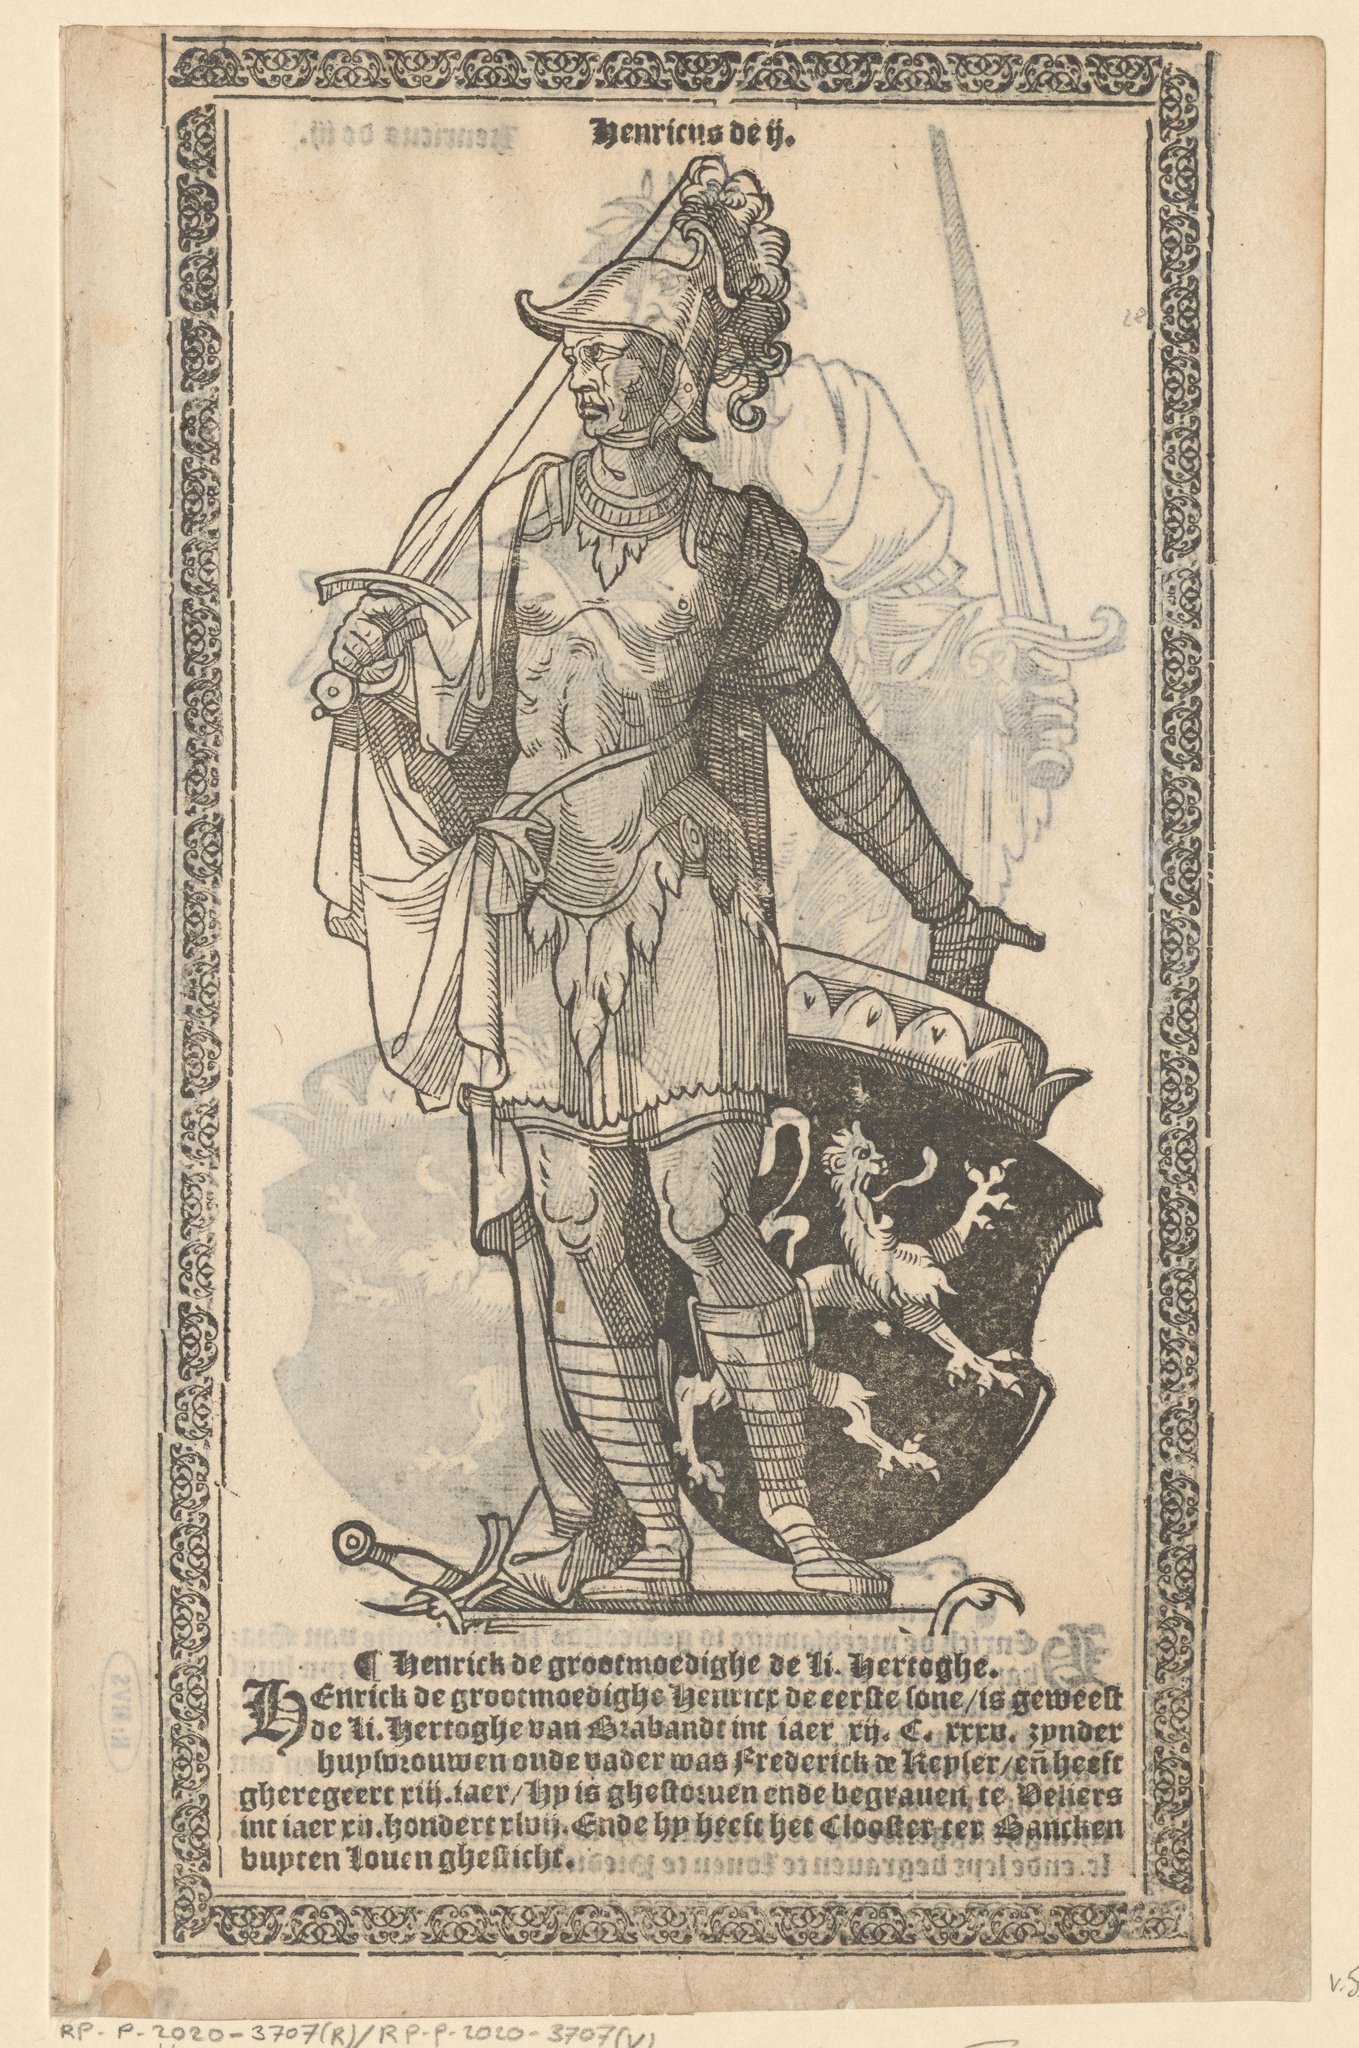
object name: print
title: Portret van Hendrik II, hertog van Brabant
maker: jan molijns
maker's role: print maker, publisher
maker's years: 1498-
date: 1565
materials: paper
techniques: letterpress printing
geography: antwerp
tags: helmet, historical persons, hacking and thrusting weapons: sword, armorial bearing, heraldry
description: Prent uit: Dit is die afcoemste ende genalogie der hertoghen ende hertoginnen van Brabandt, (...). Antwerpen: Jan Molijns, 1565.